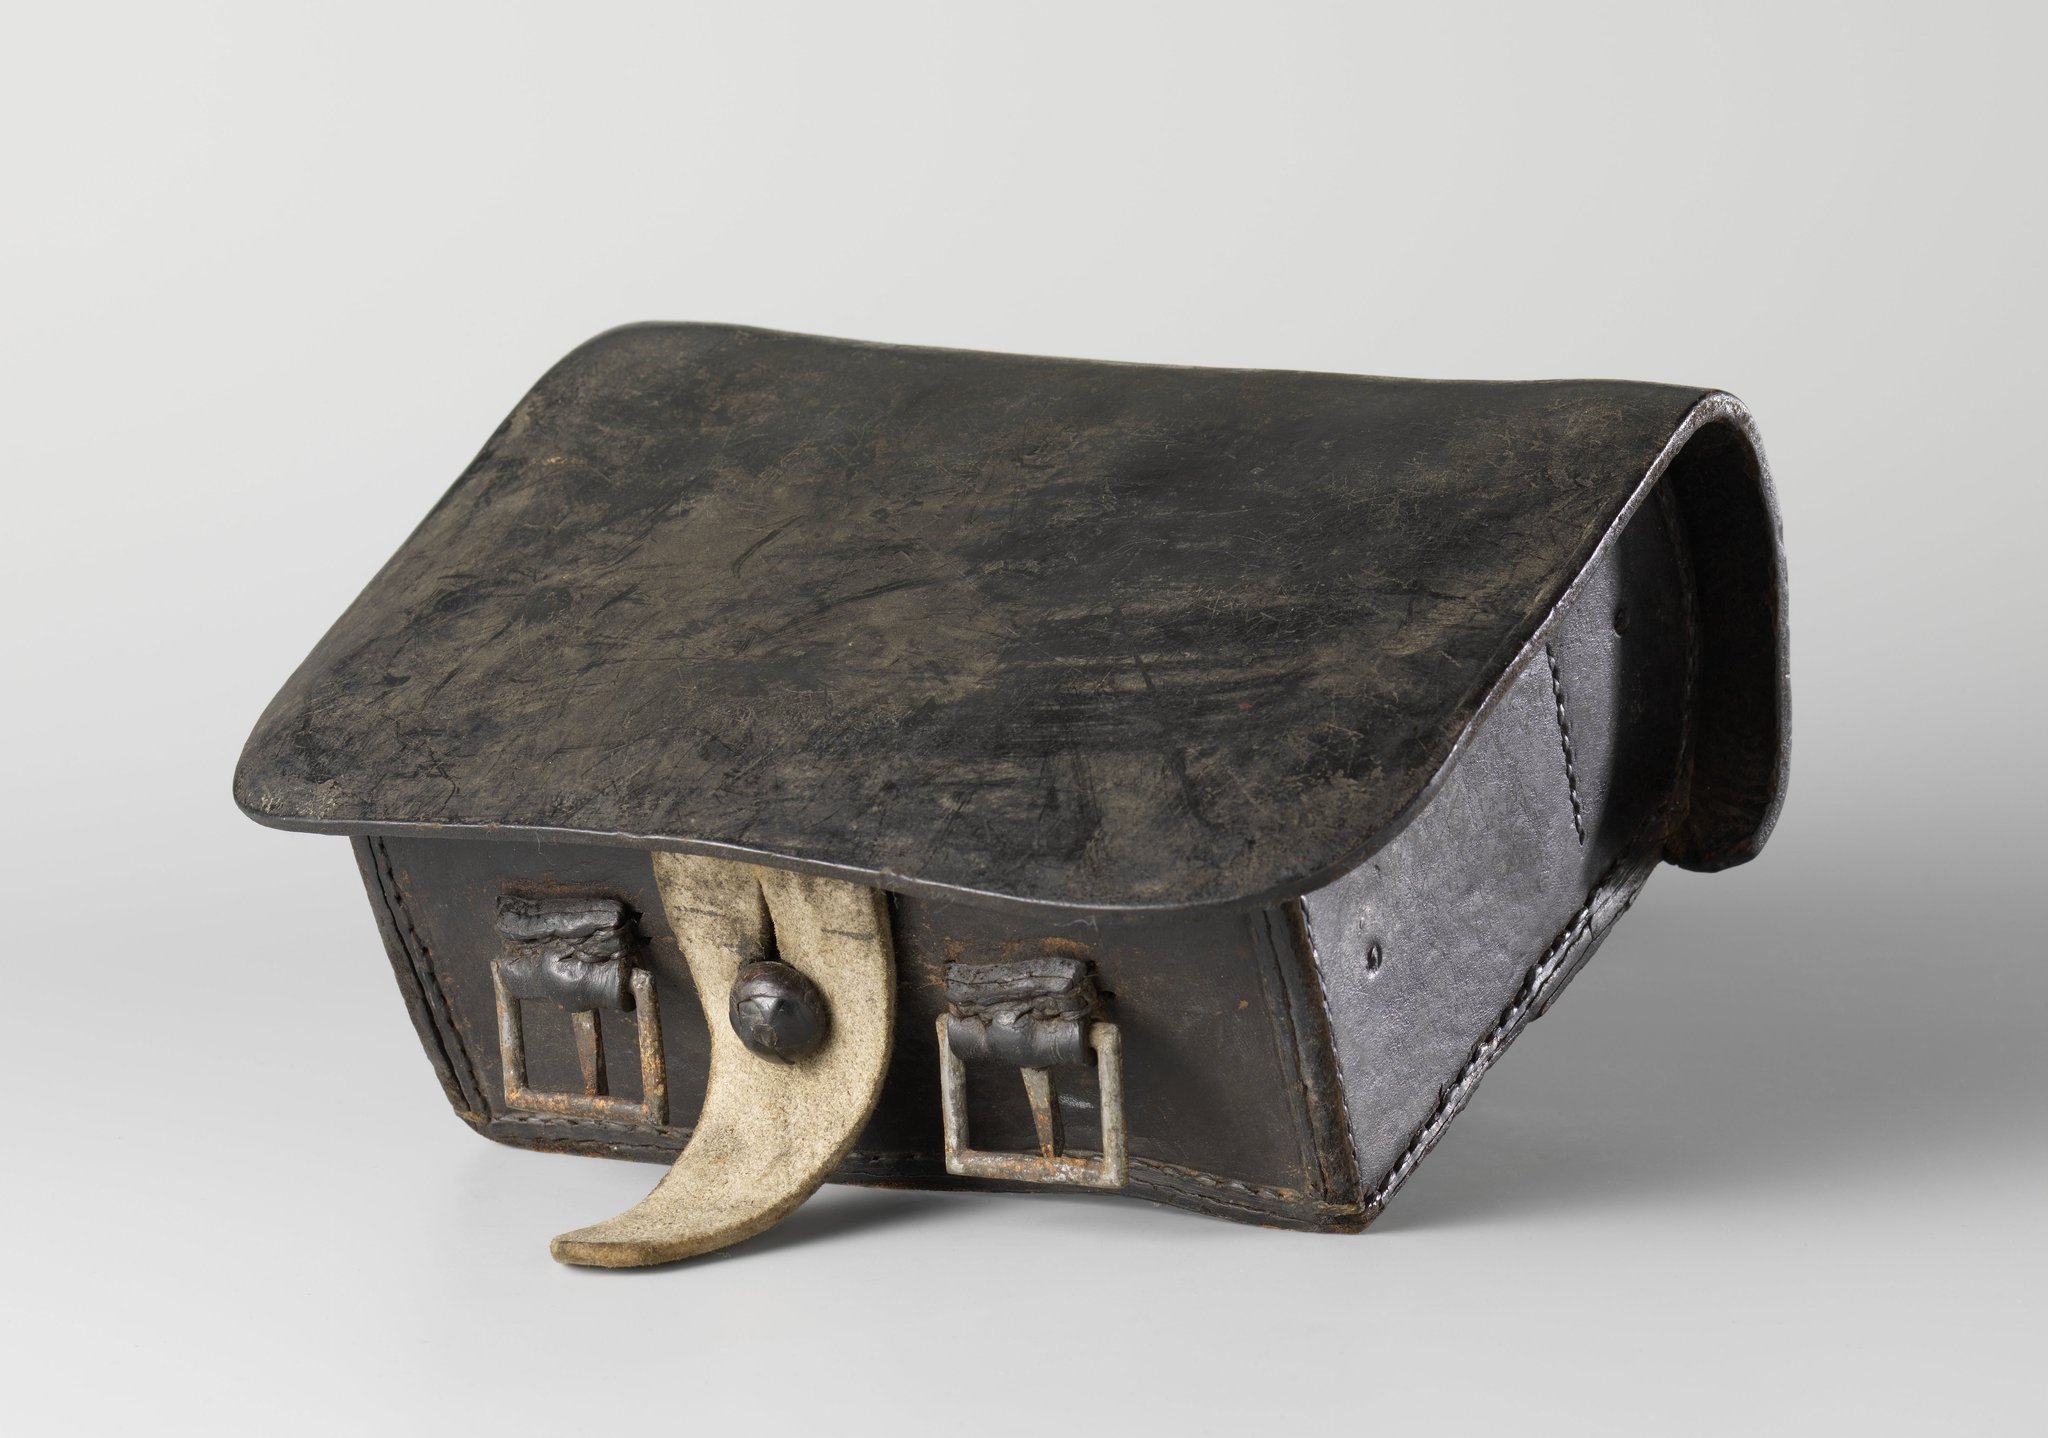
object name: cartridge pouch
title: Patroontas aan draagriem toebehoord hebbende aan J.A. Maks, in 1830-32 korporaal bij het 1e Bat. Afd. Noord-Hollandse Schutterij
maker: Anonymous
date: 1830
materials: iron, leather, clay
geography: netherlands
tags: j.a. maks, noord-holland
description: Zwarte leren rechthoekige tas met twee boven elkaar geplaatste ijzeren bakken. Onderste bak: twee vakken; bovenste bak: vier vakken. Zijkanten met flappen. Op voorzijde tas gestikte leren foudraal met twee gaten. Op onderzijde een gevlochten leren knoop en twee leren lussen met ijzeren gespen. Achterzijde twee leren gestikte lussen met twee gaten. Aan de linkerzijde een naturel leren riem met gat. Zwart leren klep met op de binnenzijde merk: HIOF IH. Achterzijde klep met wit leren riem met gat.